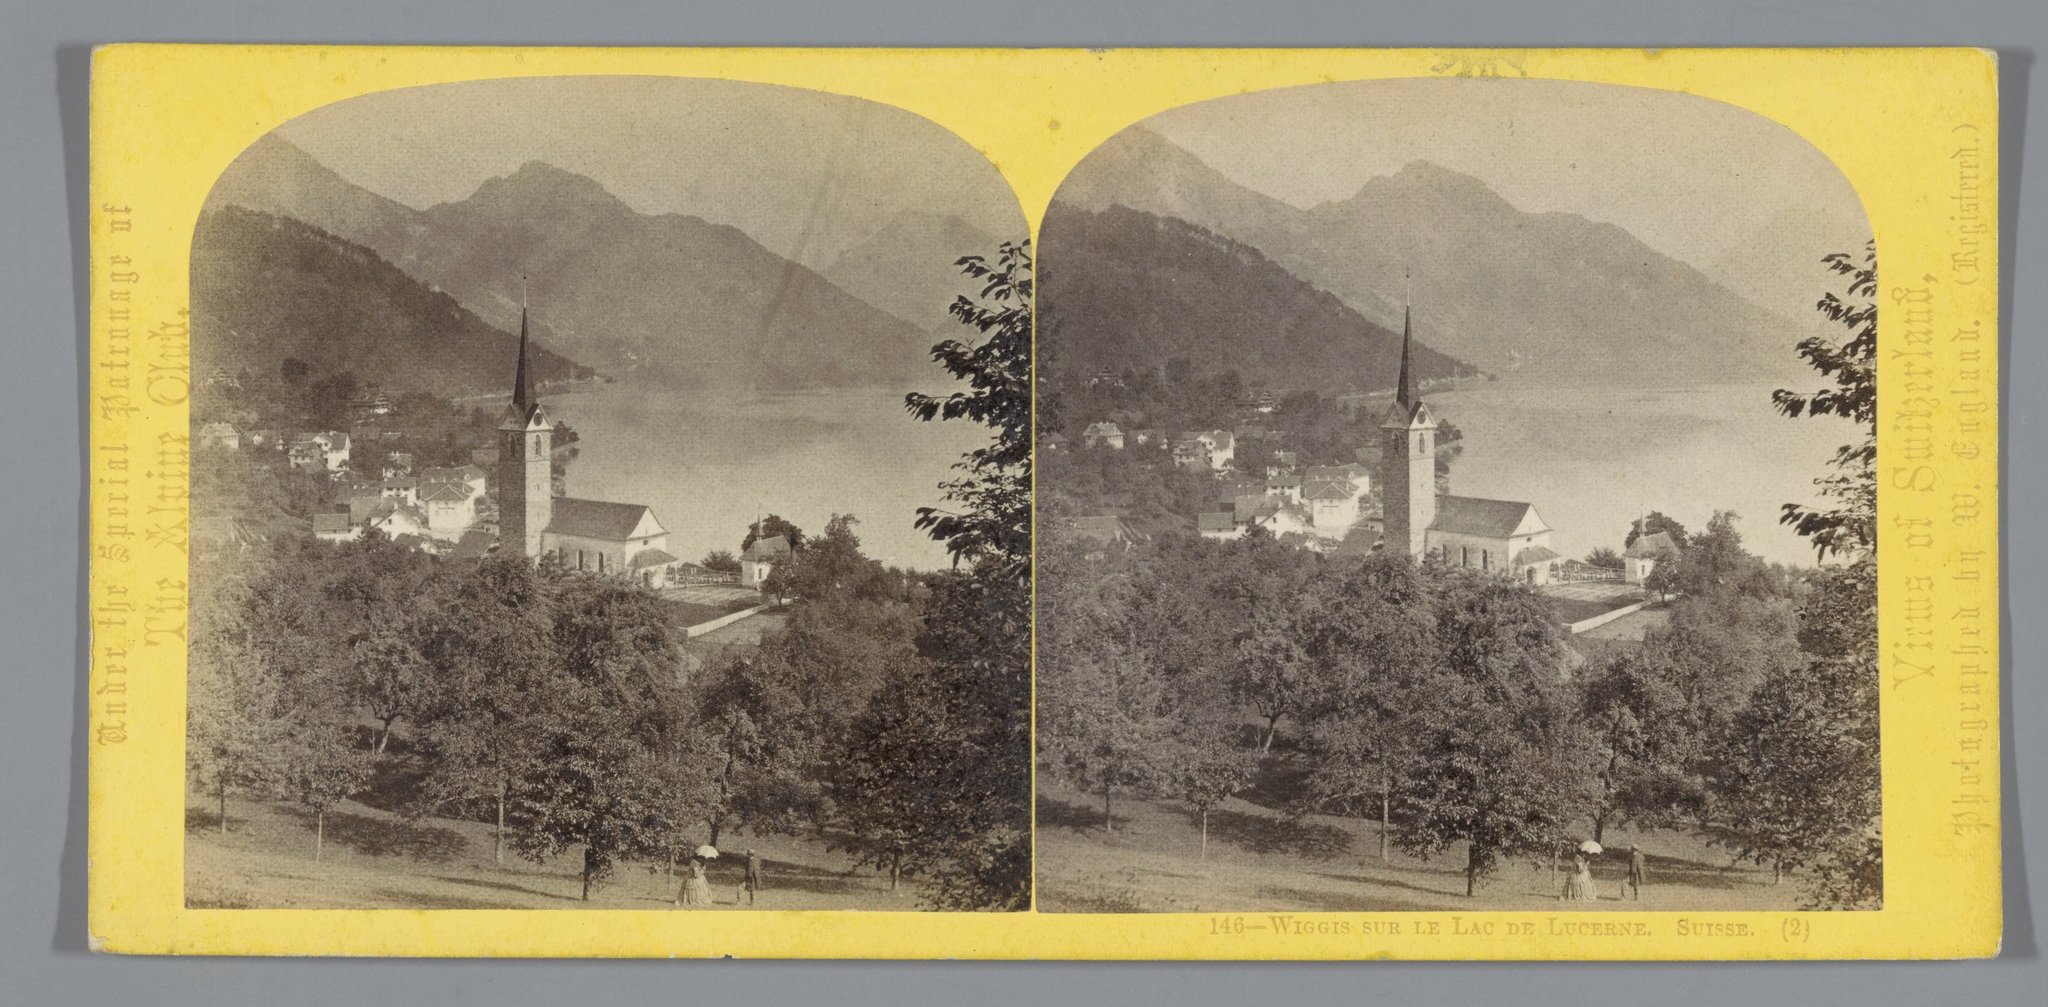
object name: stereograph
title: Gezicht op Weggis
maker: william england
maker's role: fotograaf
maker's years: 1816-1896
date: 1850-1880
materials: cardboard, photographic support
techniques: albumen print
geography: weggis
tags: city-view in general; 'veduta'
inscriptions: inscription: ‘Views of Switzerland, photographed by W. England. (Registered) Under the Special Patronage of the Alpine Club.’, number: ‘146’